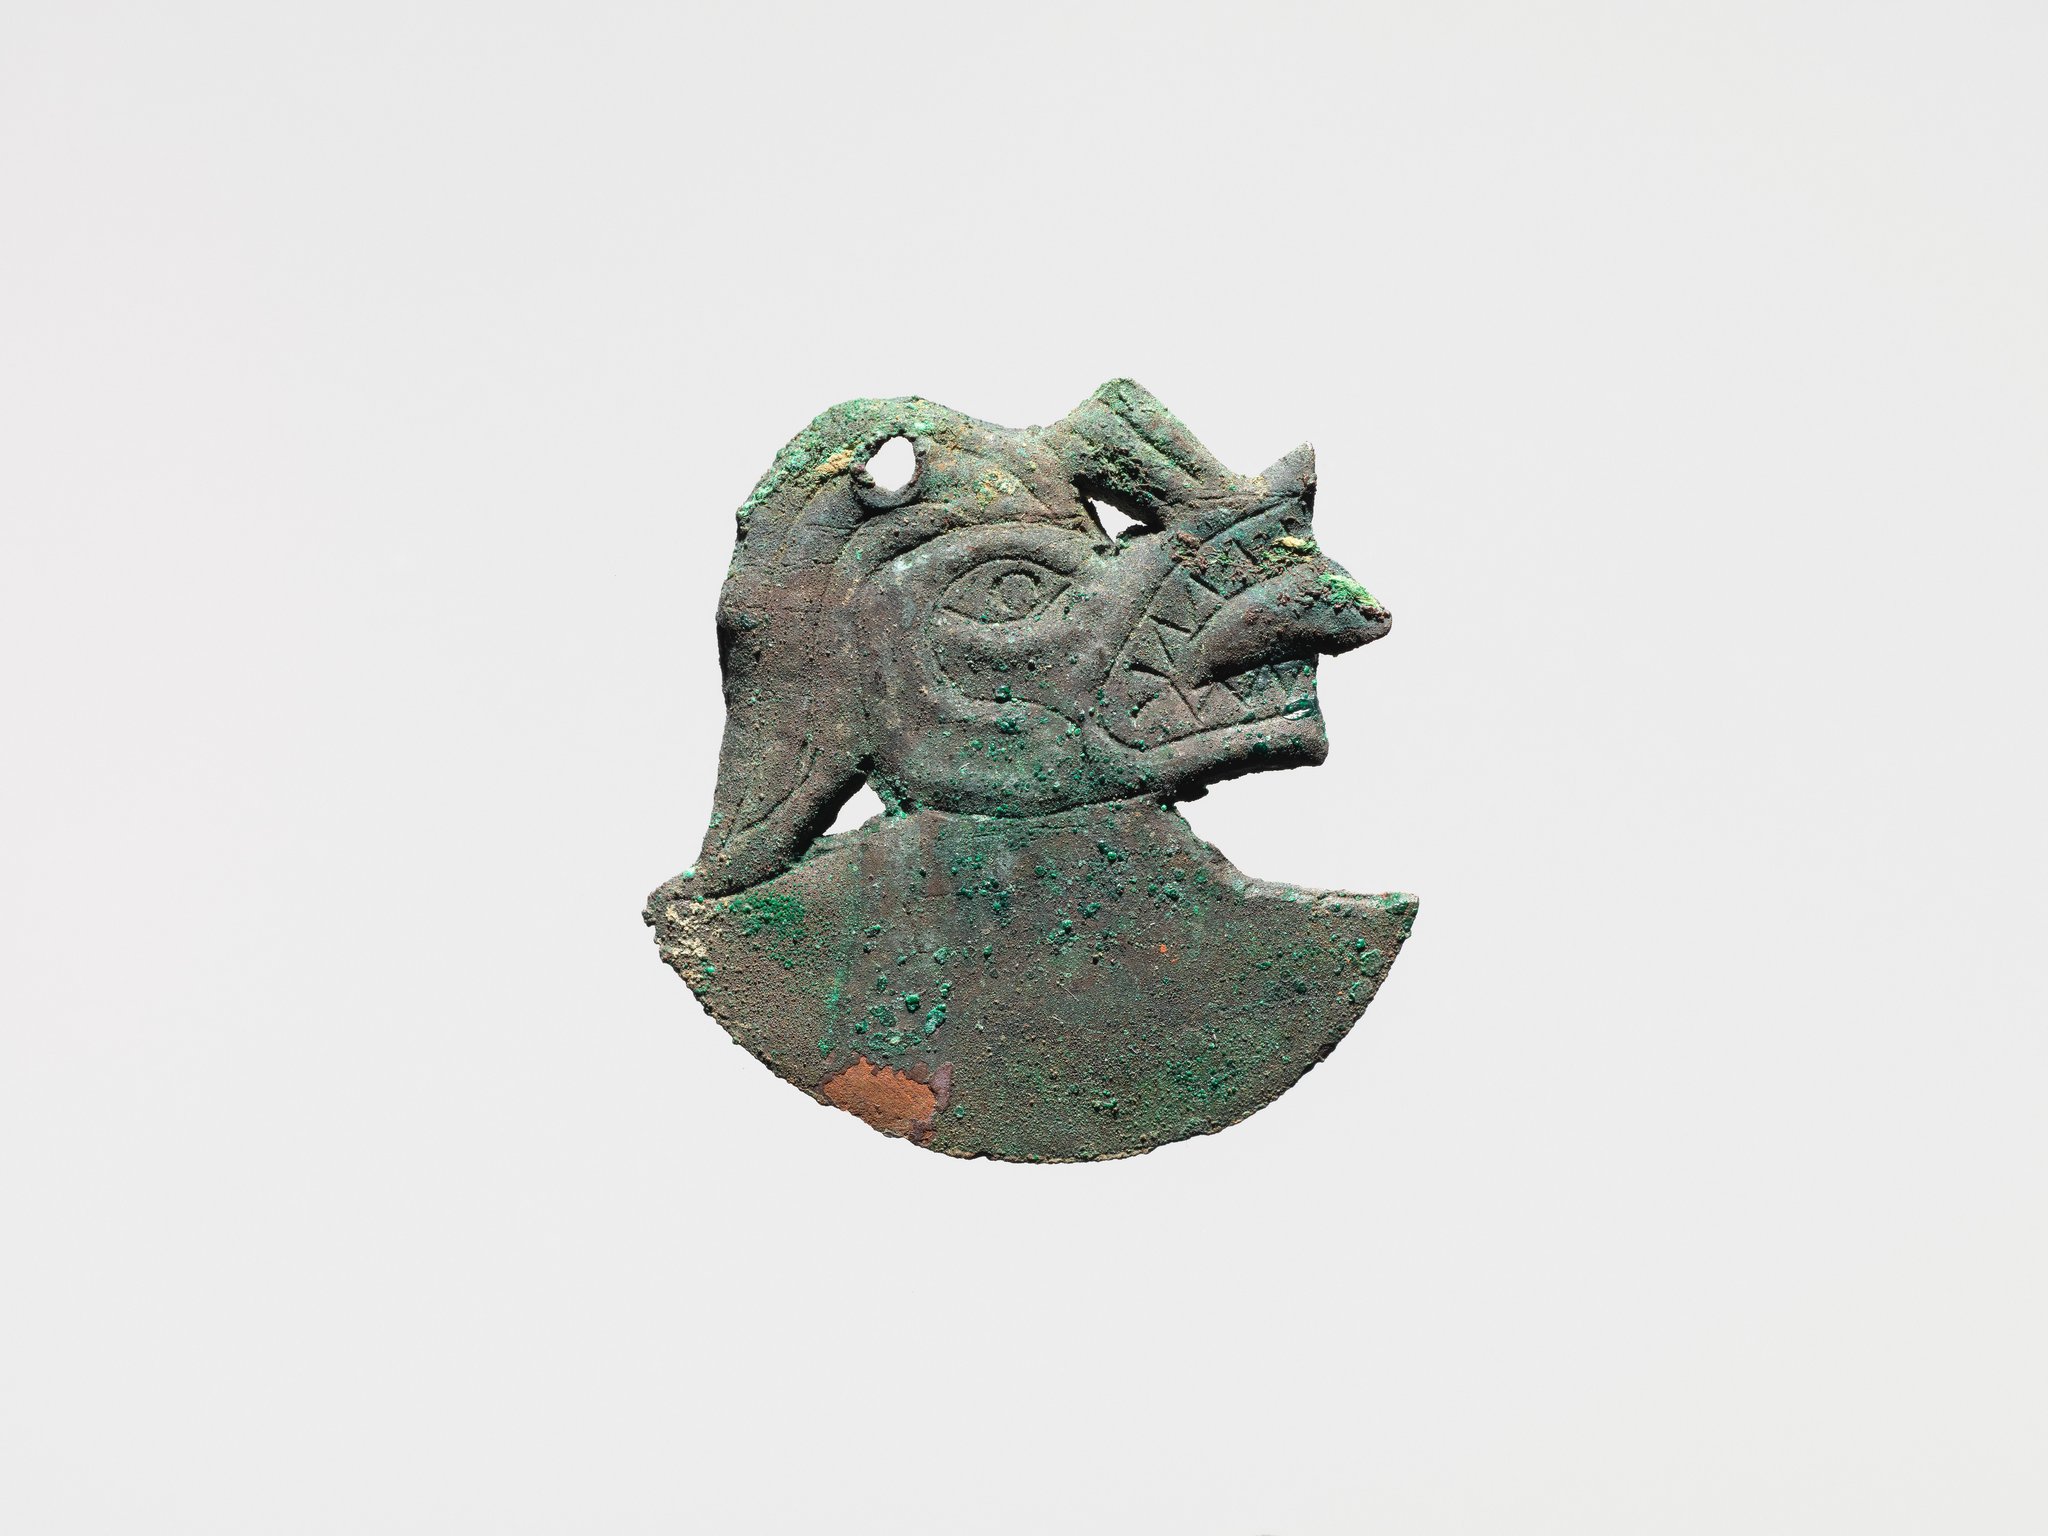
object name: ornament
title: Crescent Ornaments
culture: moche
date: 501-700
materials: copper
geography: peru